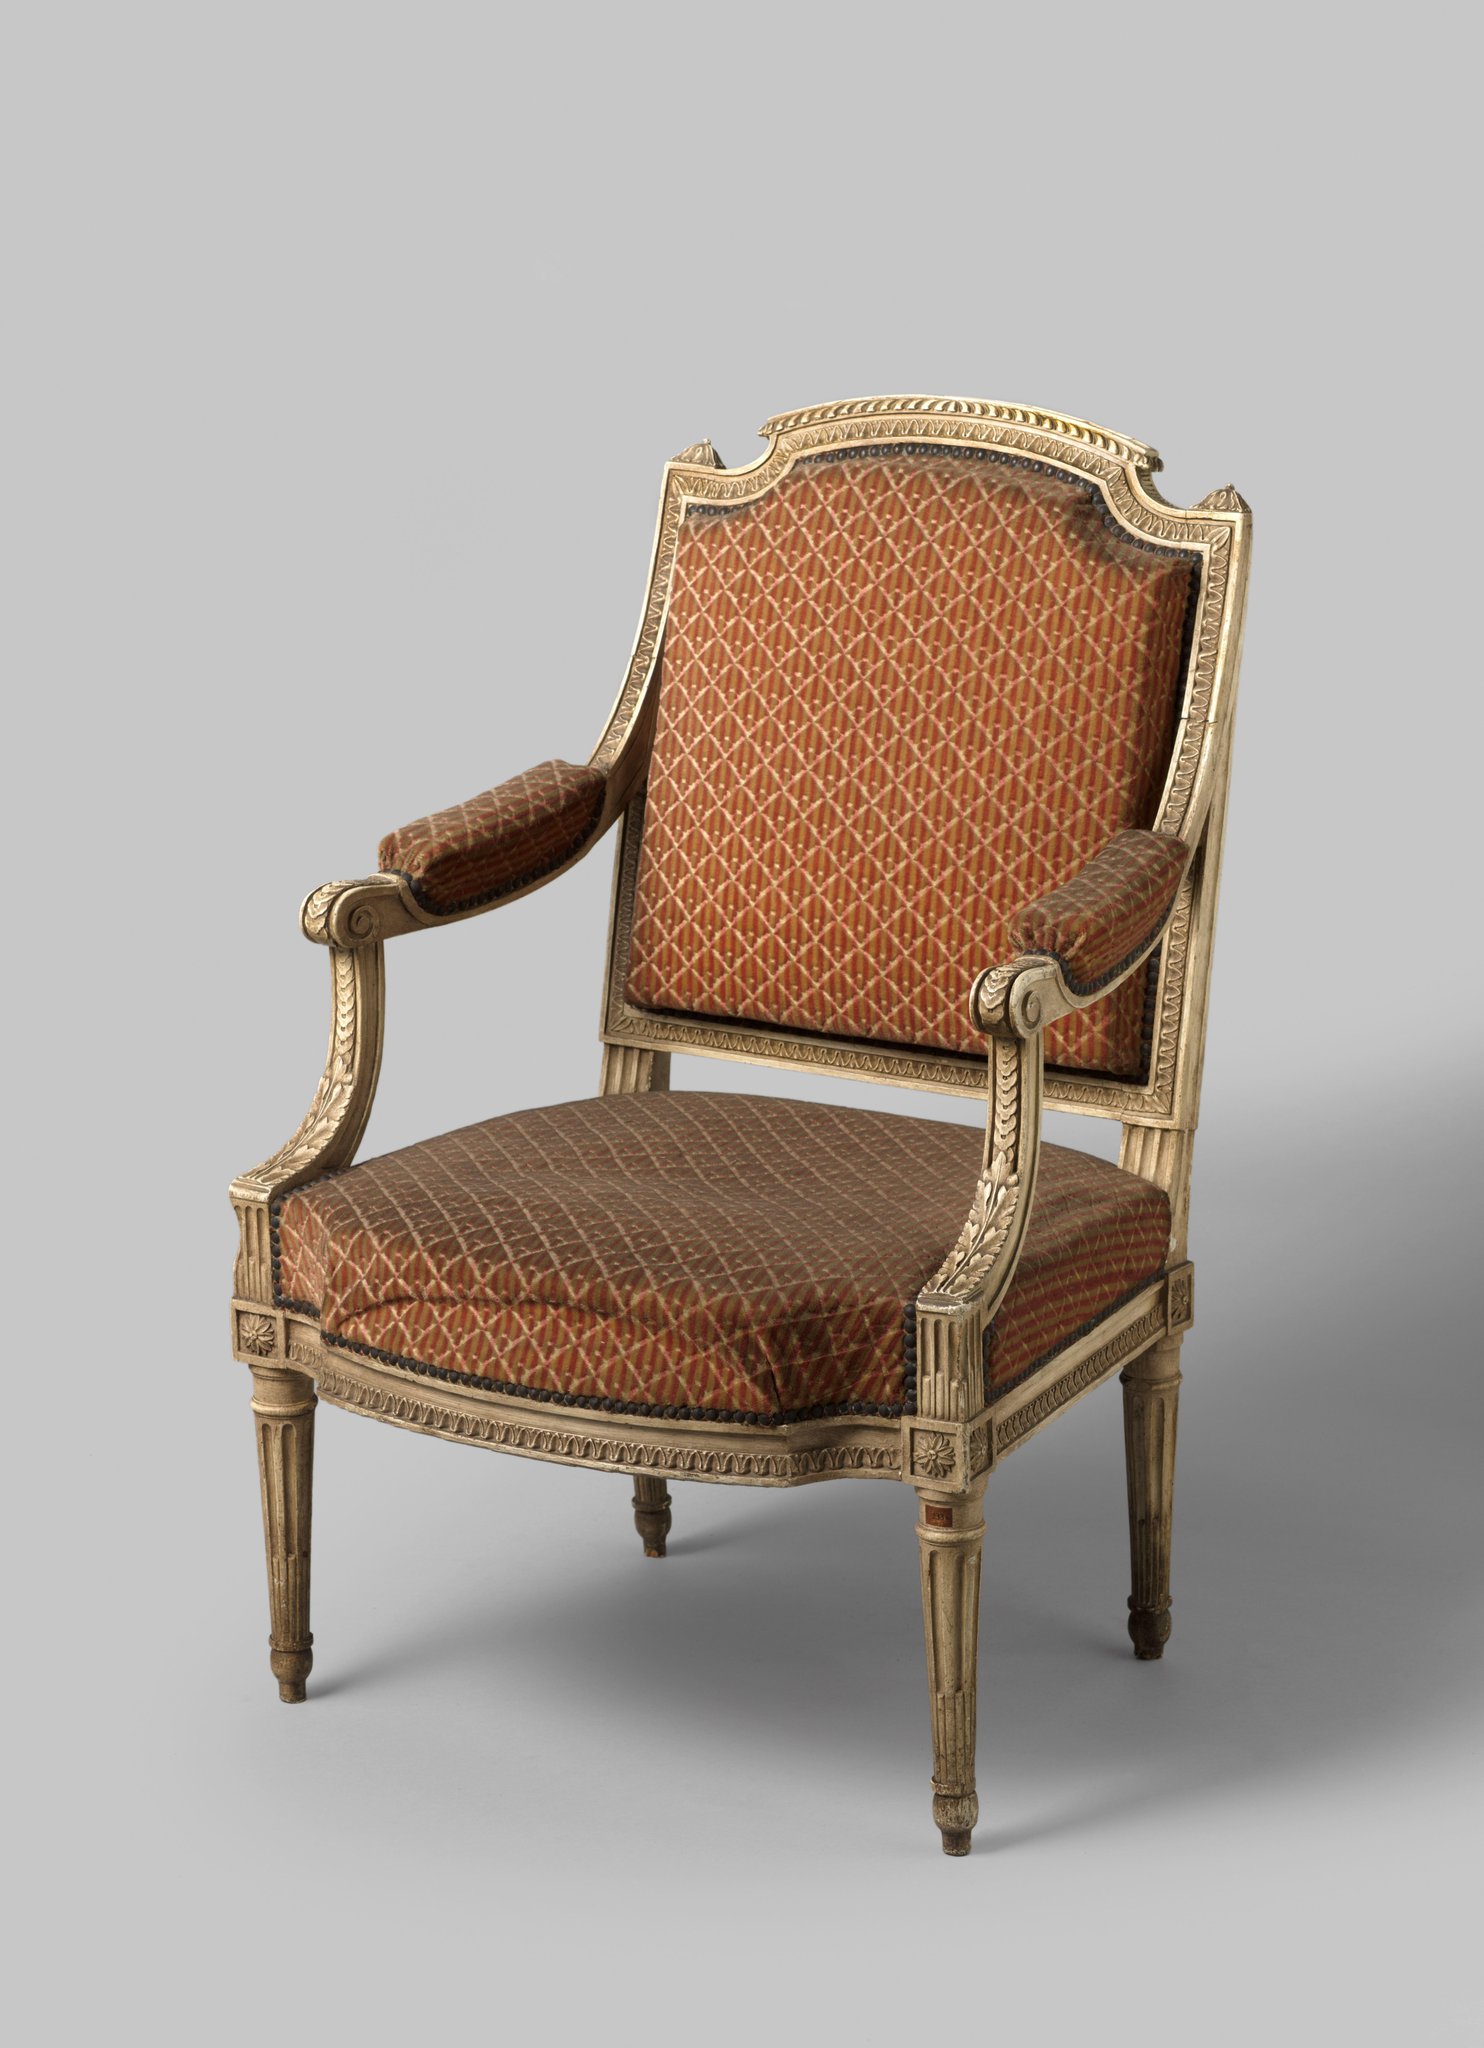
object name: armchair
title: Armstoel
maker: françois claude menant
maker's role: furniture worker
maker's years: 1757-1793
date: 1775-1800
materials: wood, paint, textile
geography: france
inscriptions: mark: ‘F.C. Menant’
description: Armstoel, bekleed, van wit geschilderd beukenhout en rustend op conische gecanneleerde poten, onder vierkante huizen met rozetten. De vierkante armleggerstutten hebben gecanneleerde basementen, gestoken vlechtornament en acanthusblad en steunen de armleggers, eindigend in een voluut. Het trapeziumvormige zitraam is uitgebogen. De lichtgebogen bovendorpel van het rugraam, versierd met knorrenlijst, heeft uitgeronde hoeken; de stijlen eindigen in rozetten. Zitregels en rugraam dragen gestoken schubversiering. Gestempeld onder aan de voorzitregel: F.C. Menant